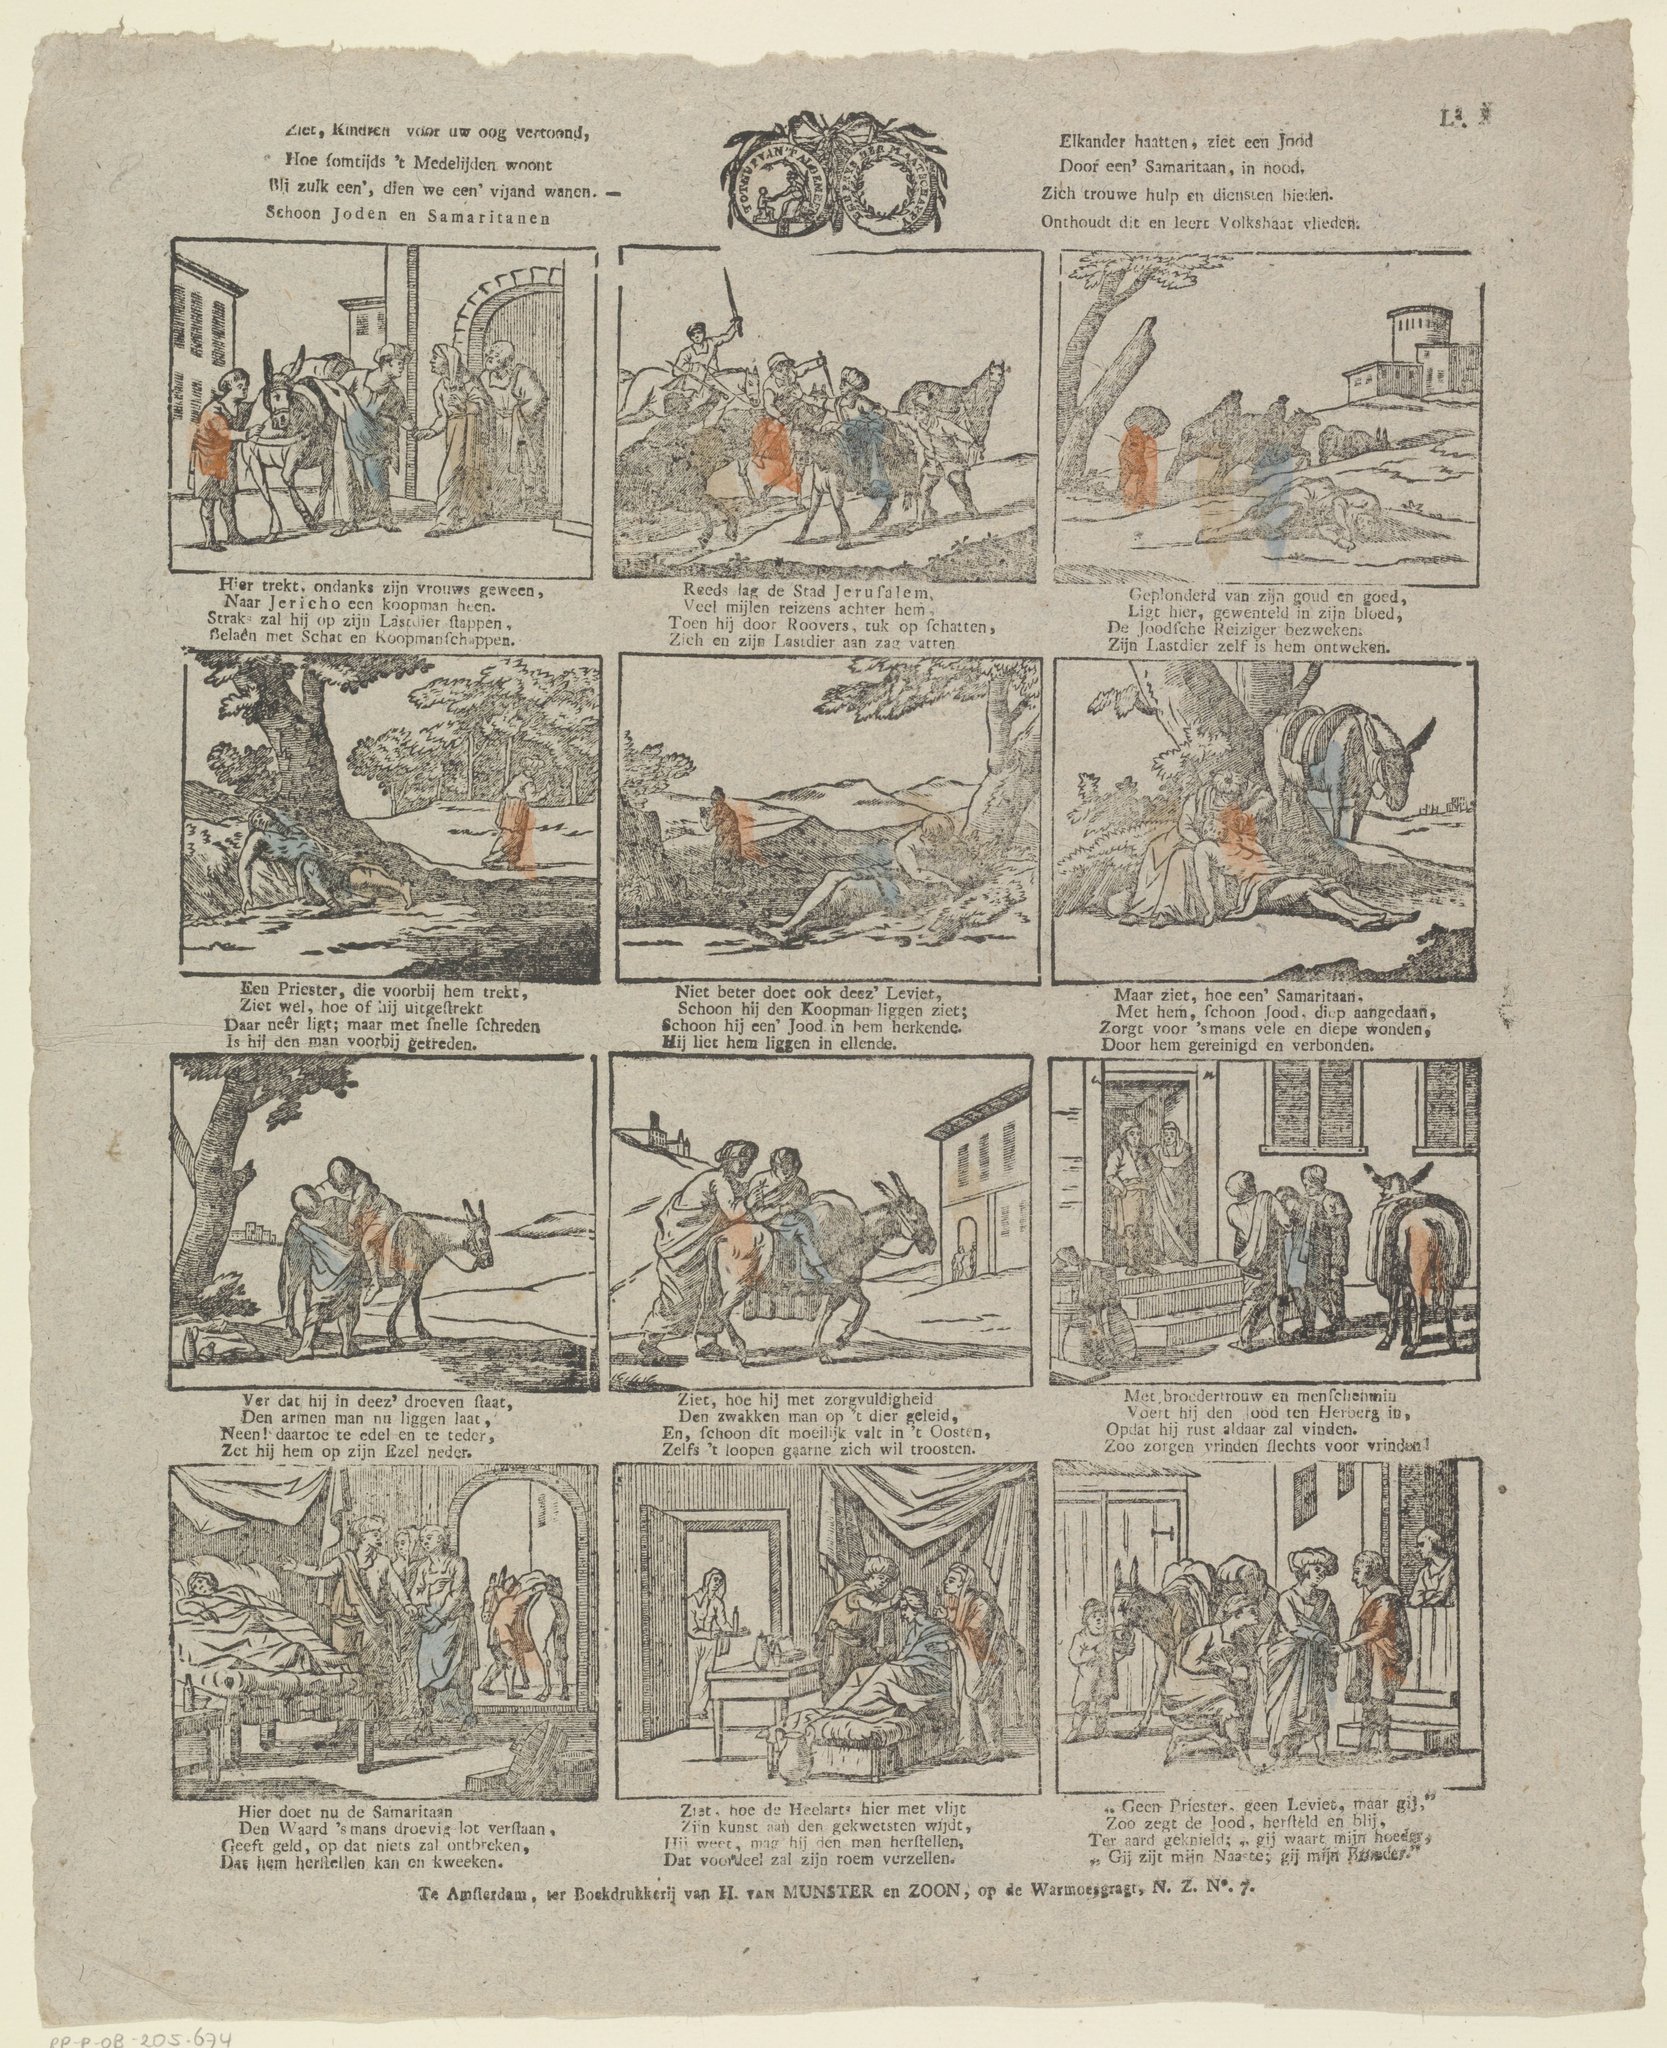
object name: print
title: Ziet kindren! voor uw oog vertoond, / Hoe somtijds 't medelijden woont [(...)]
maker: Anonymous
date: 1811-1829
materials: paper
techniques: colour, letterpress printing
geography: netherlands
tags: the good samaritan (luke 10:30-37)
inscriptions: collector's mark: Lugt 2760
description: Blad met 12 voorstellingen van het verhaal van de Barmhartige Samaritaan. Midden boven het zegel van de Maatschappij tot Nut van 't Algemeen. Onder elke afbeelding een vierregelig vers. Genummerd rechtsboven: L.X.